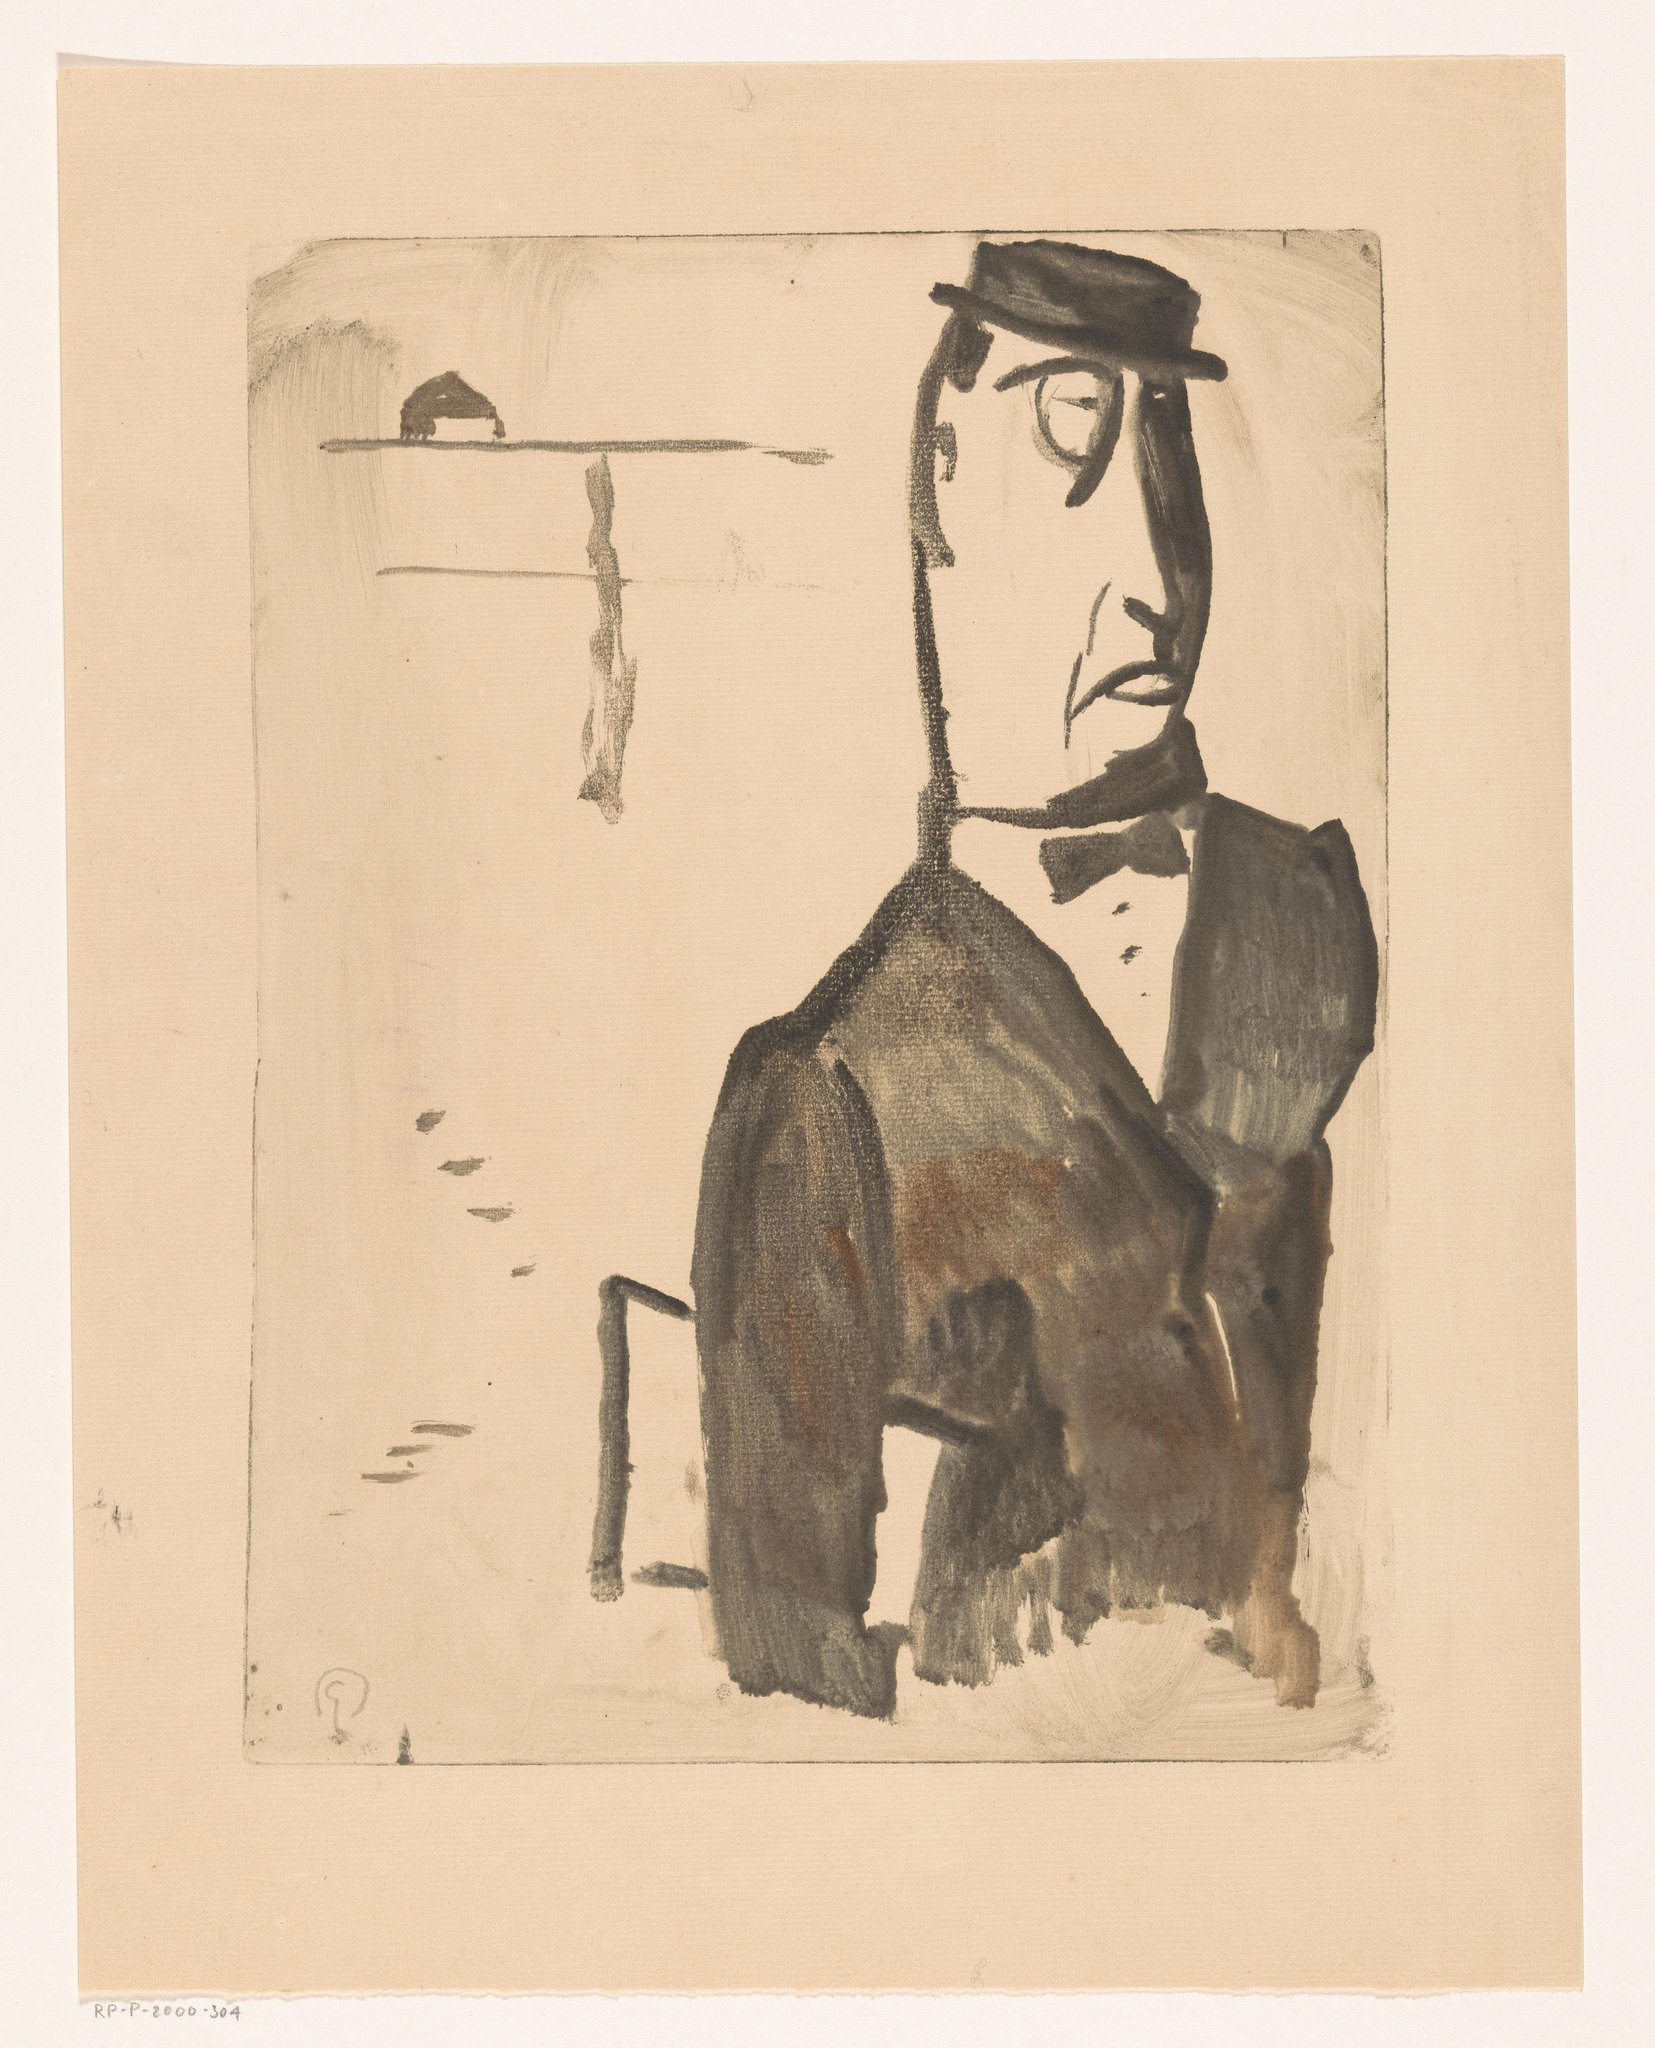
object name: print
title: Man met vlinderdas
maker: gerrit van der hoef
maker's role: print maker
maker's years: 1879-1954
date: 1940-1954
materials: paper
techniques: monotype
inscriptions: signature: ‘G’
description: Een man met hoed op en vlinderdas om, een aktetas onder zijn arm, ten halven lijve, naar rechts.